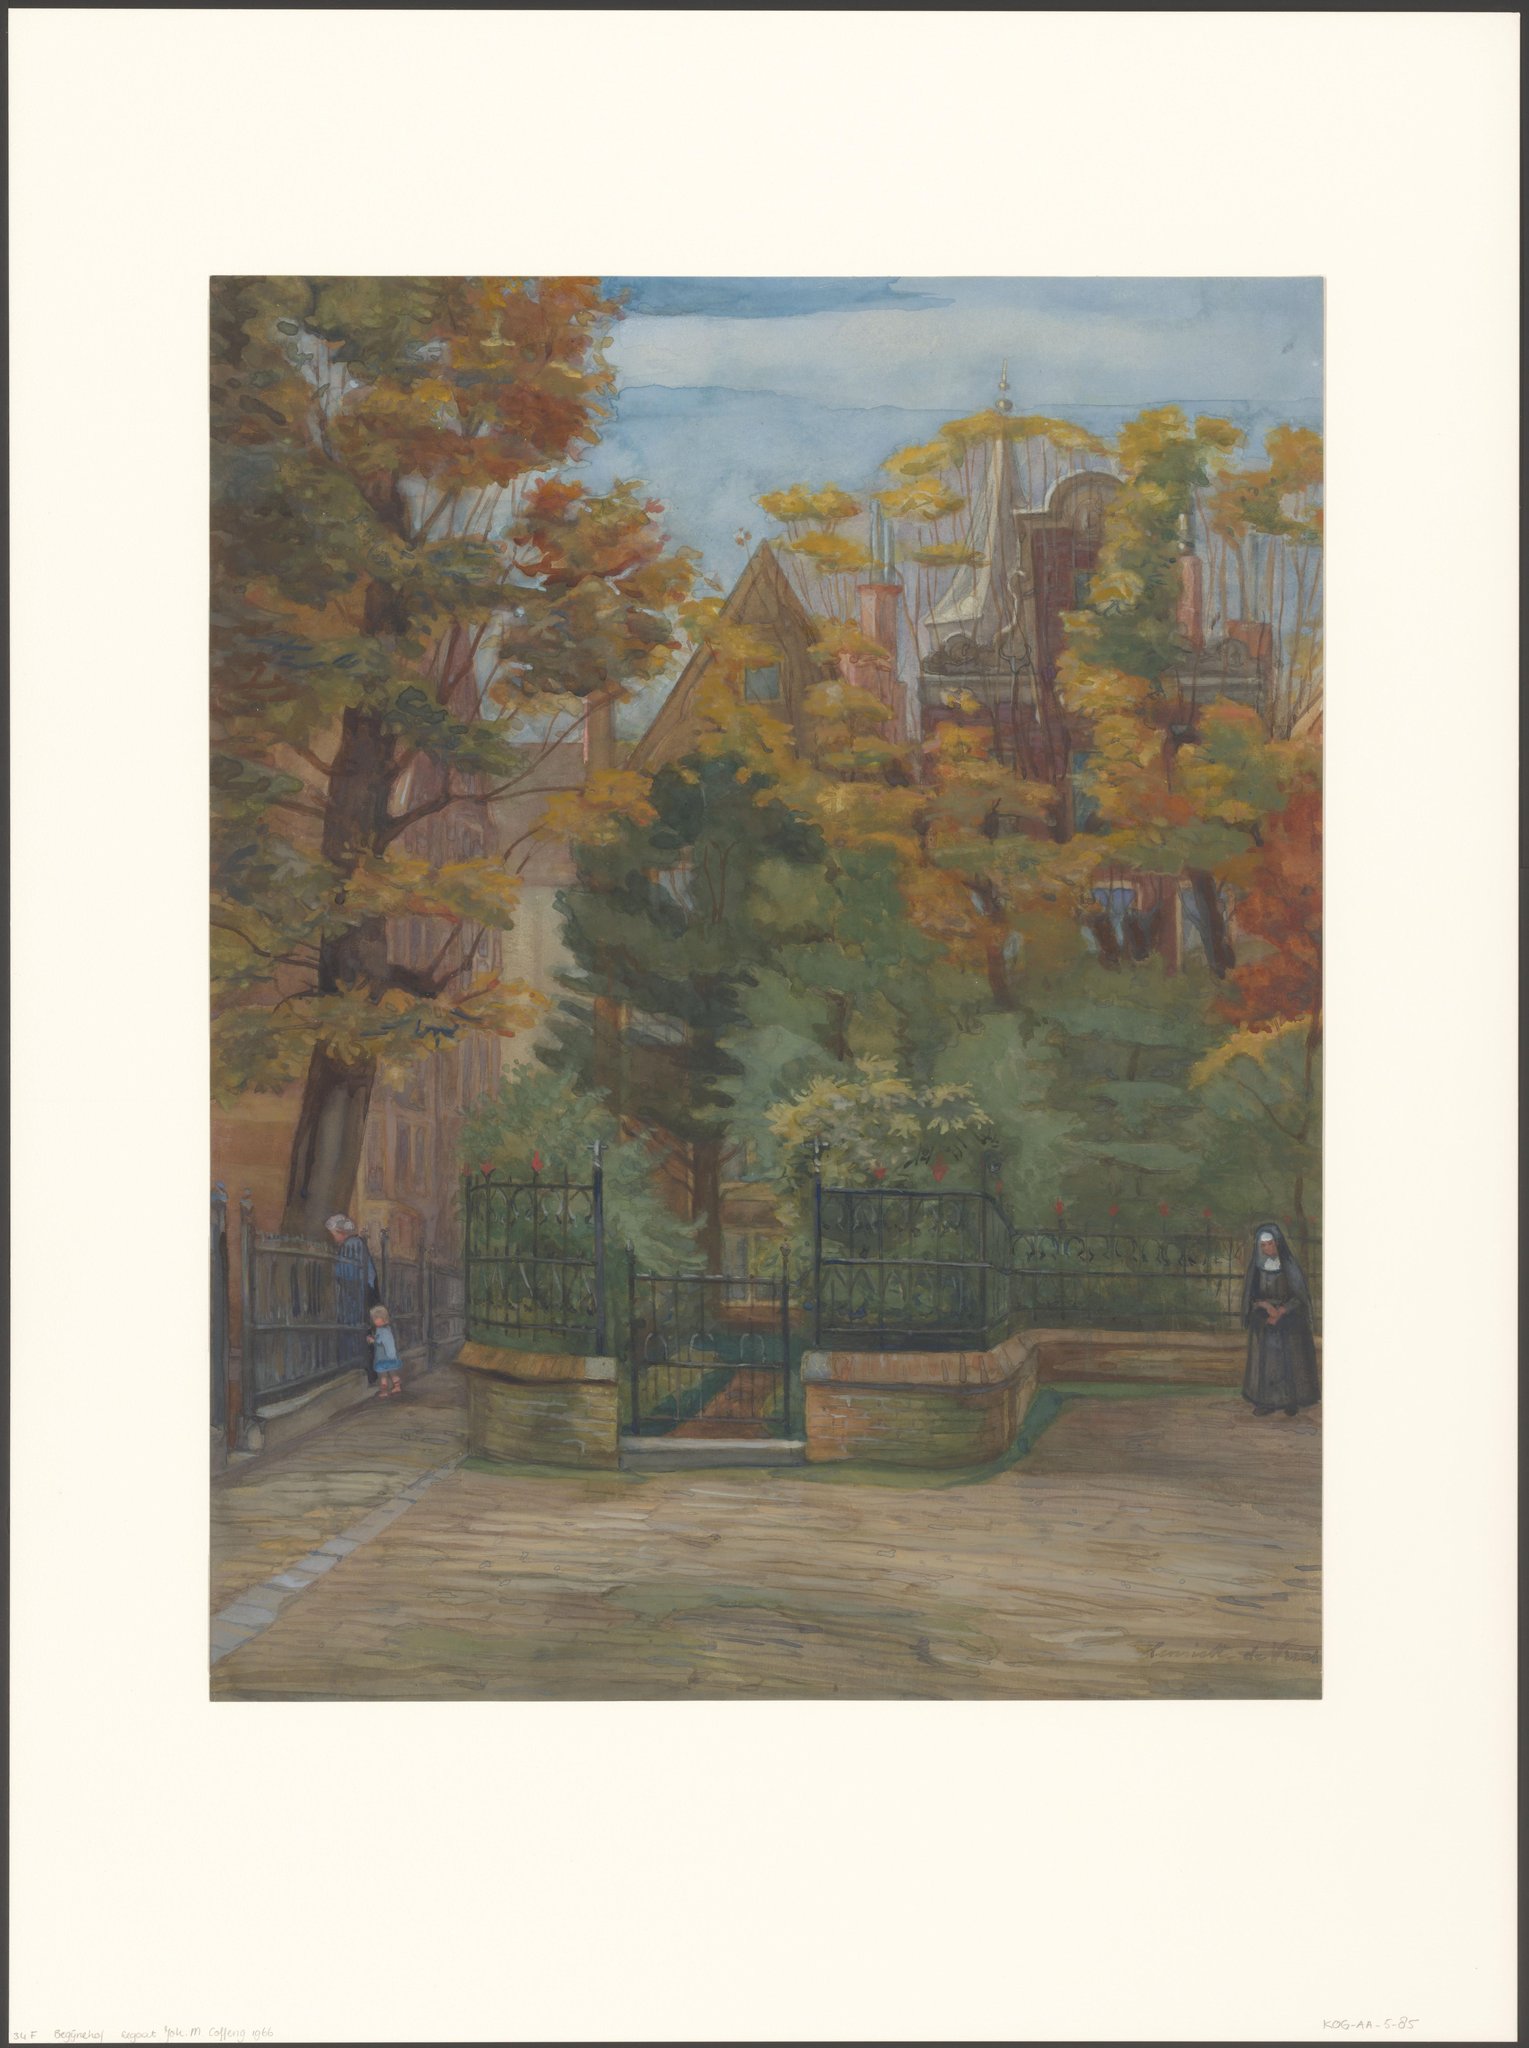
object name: drawing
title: Gezicht op het Begijnhof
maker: henriëtte de vries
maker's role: draughtsman, print maker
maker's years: 1867-1942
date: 1877-1942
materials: chalk, paint, gouache, paper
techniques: brush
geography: amsterdam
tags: alms-house (dutch: 'hofje'), city-view in general; 'veduta'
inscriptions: inscription: ‘701 devries / Henriette deVries / 1867-1942 / Veiling Bo[...]n / 24Dec 1942’, signature: ‘Henriette de Vries’